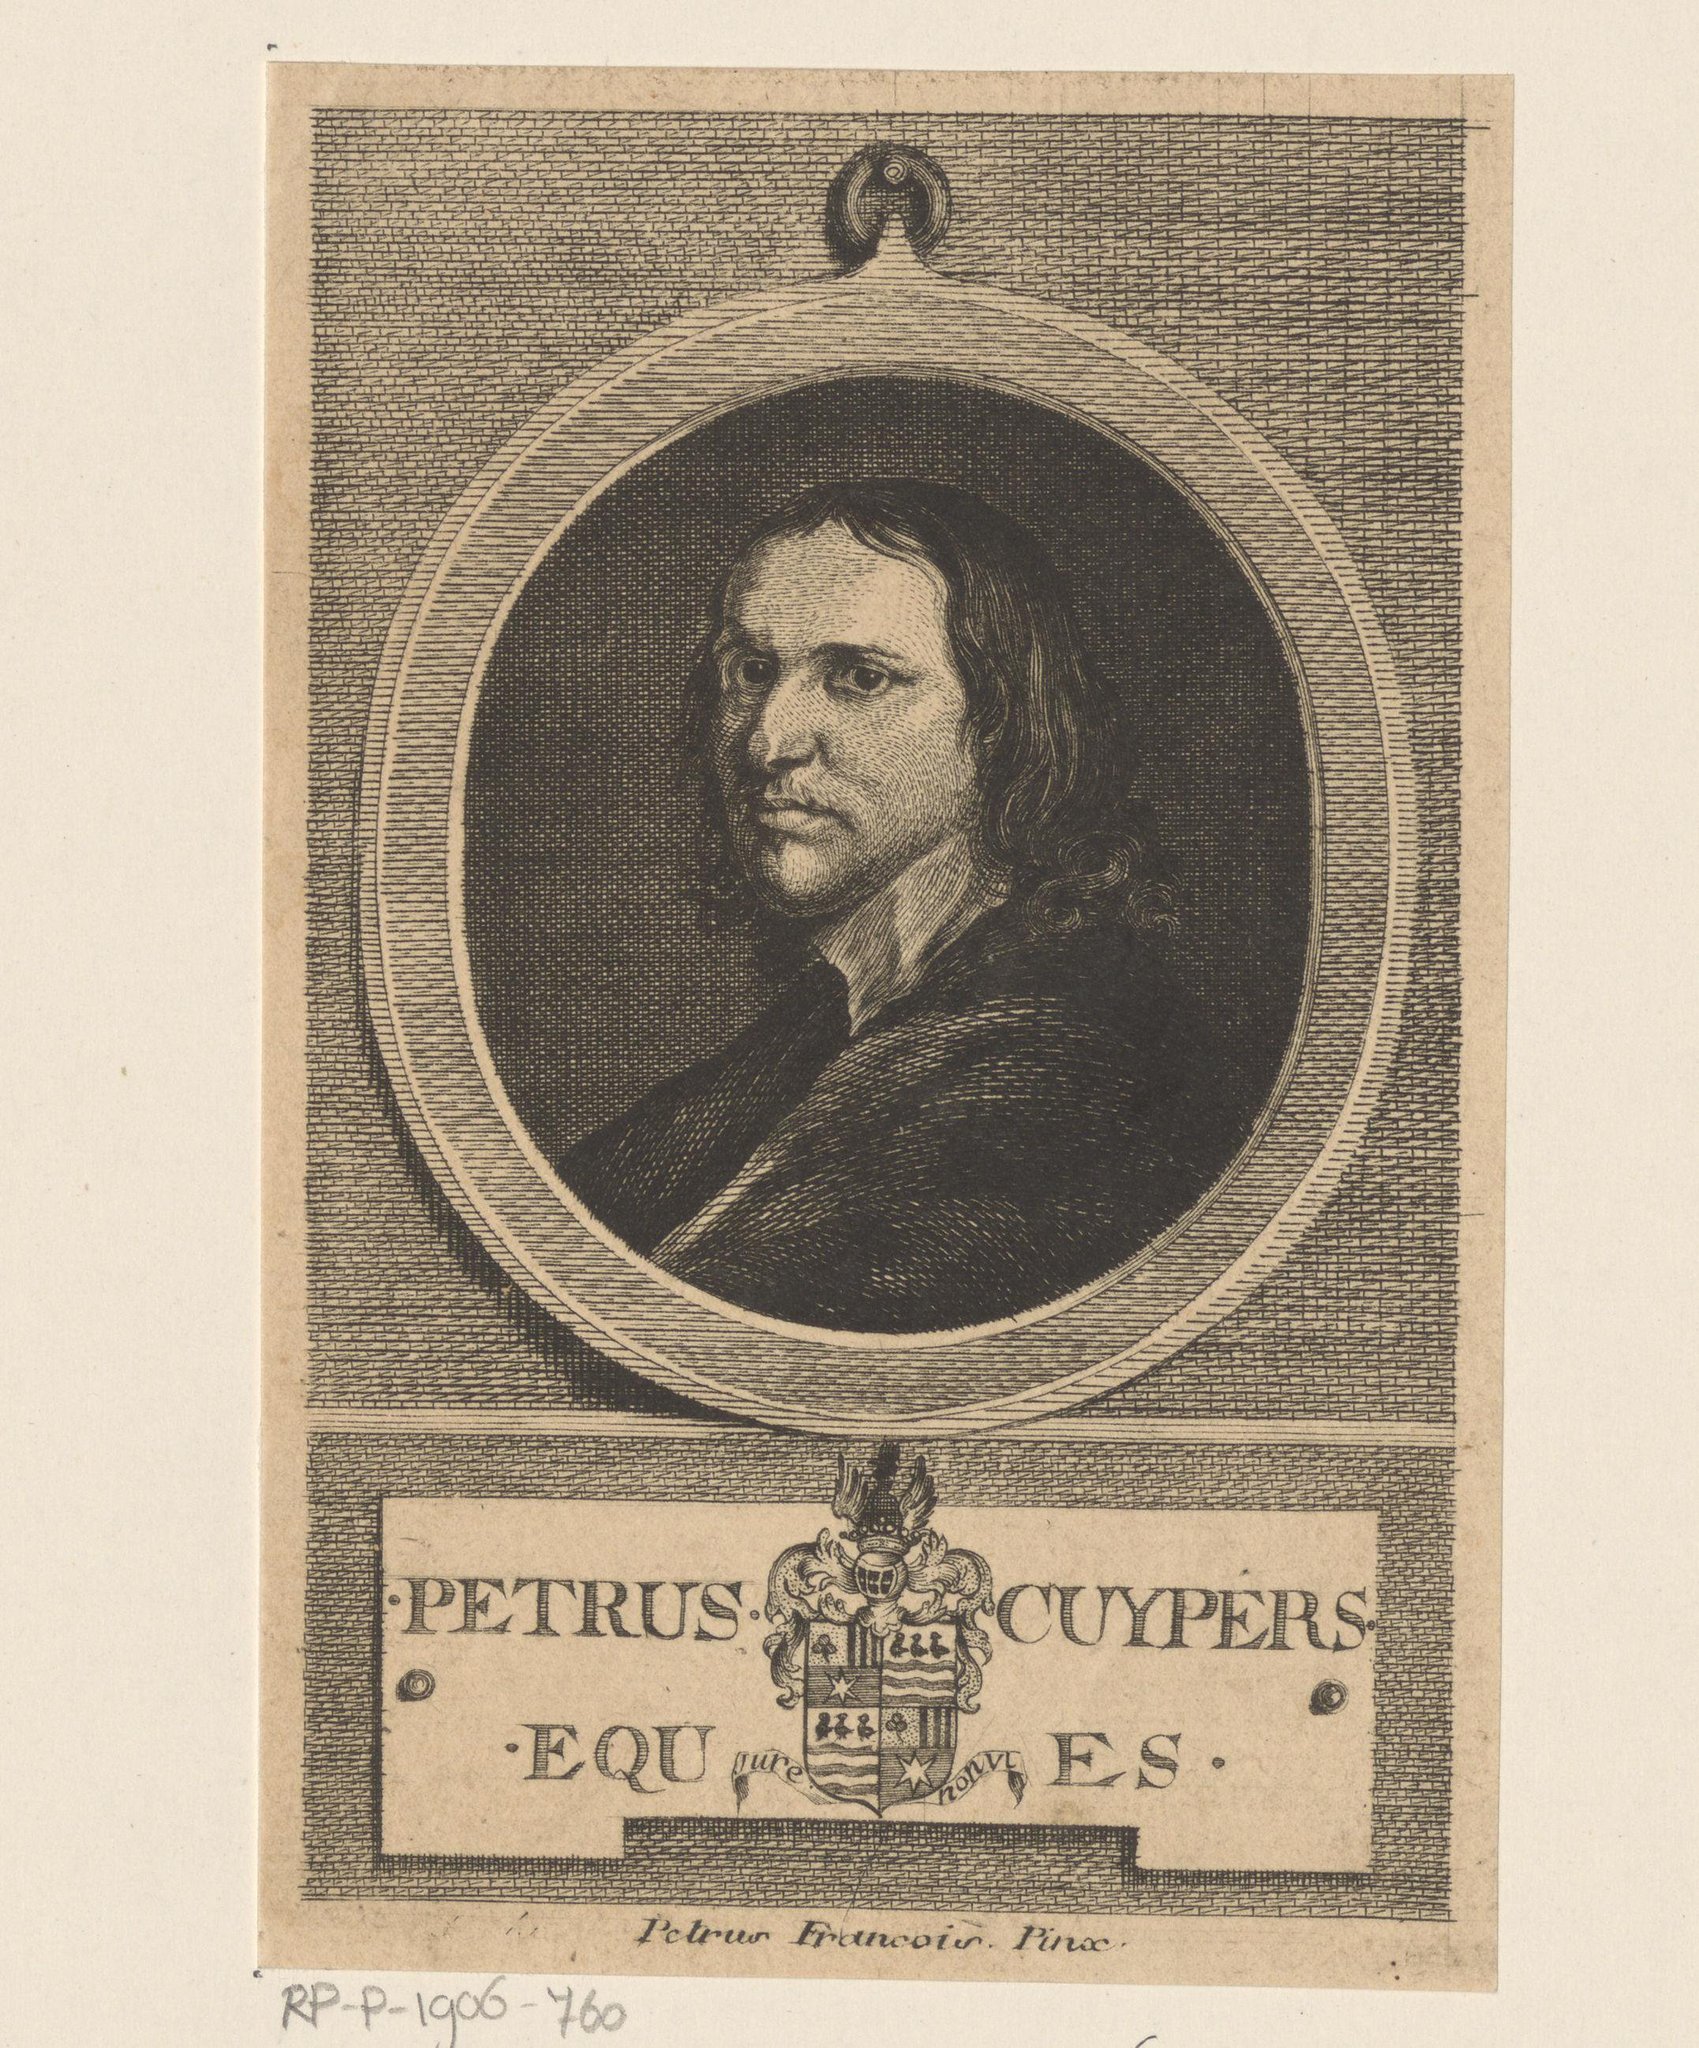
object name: print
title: Portret van Petrus Cuypers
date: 1640-1699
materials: paper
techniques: engraving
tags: mechelen, historical persons, armorial bearing, heraldry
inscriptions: collector's mark: Lugt 2228